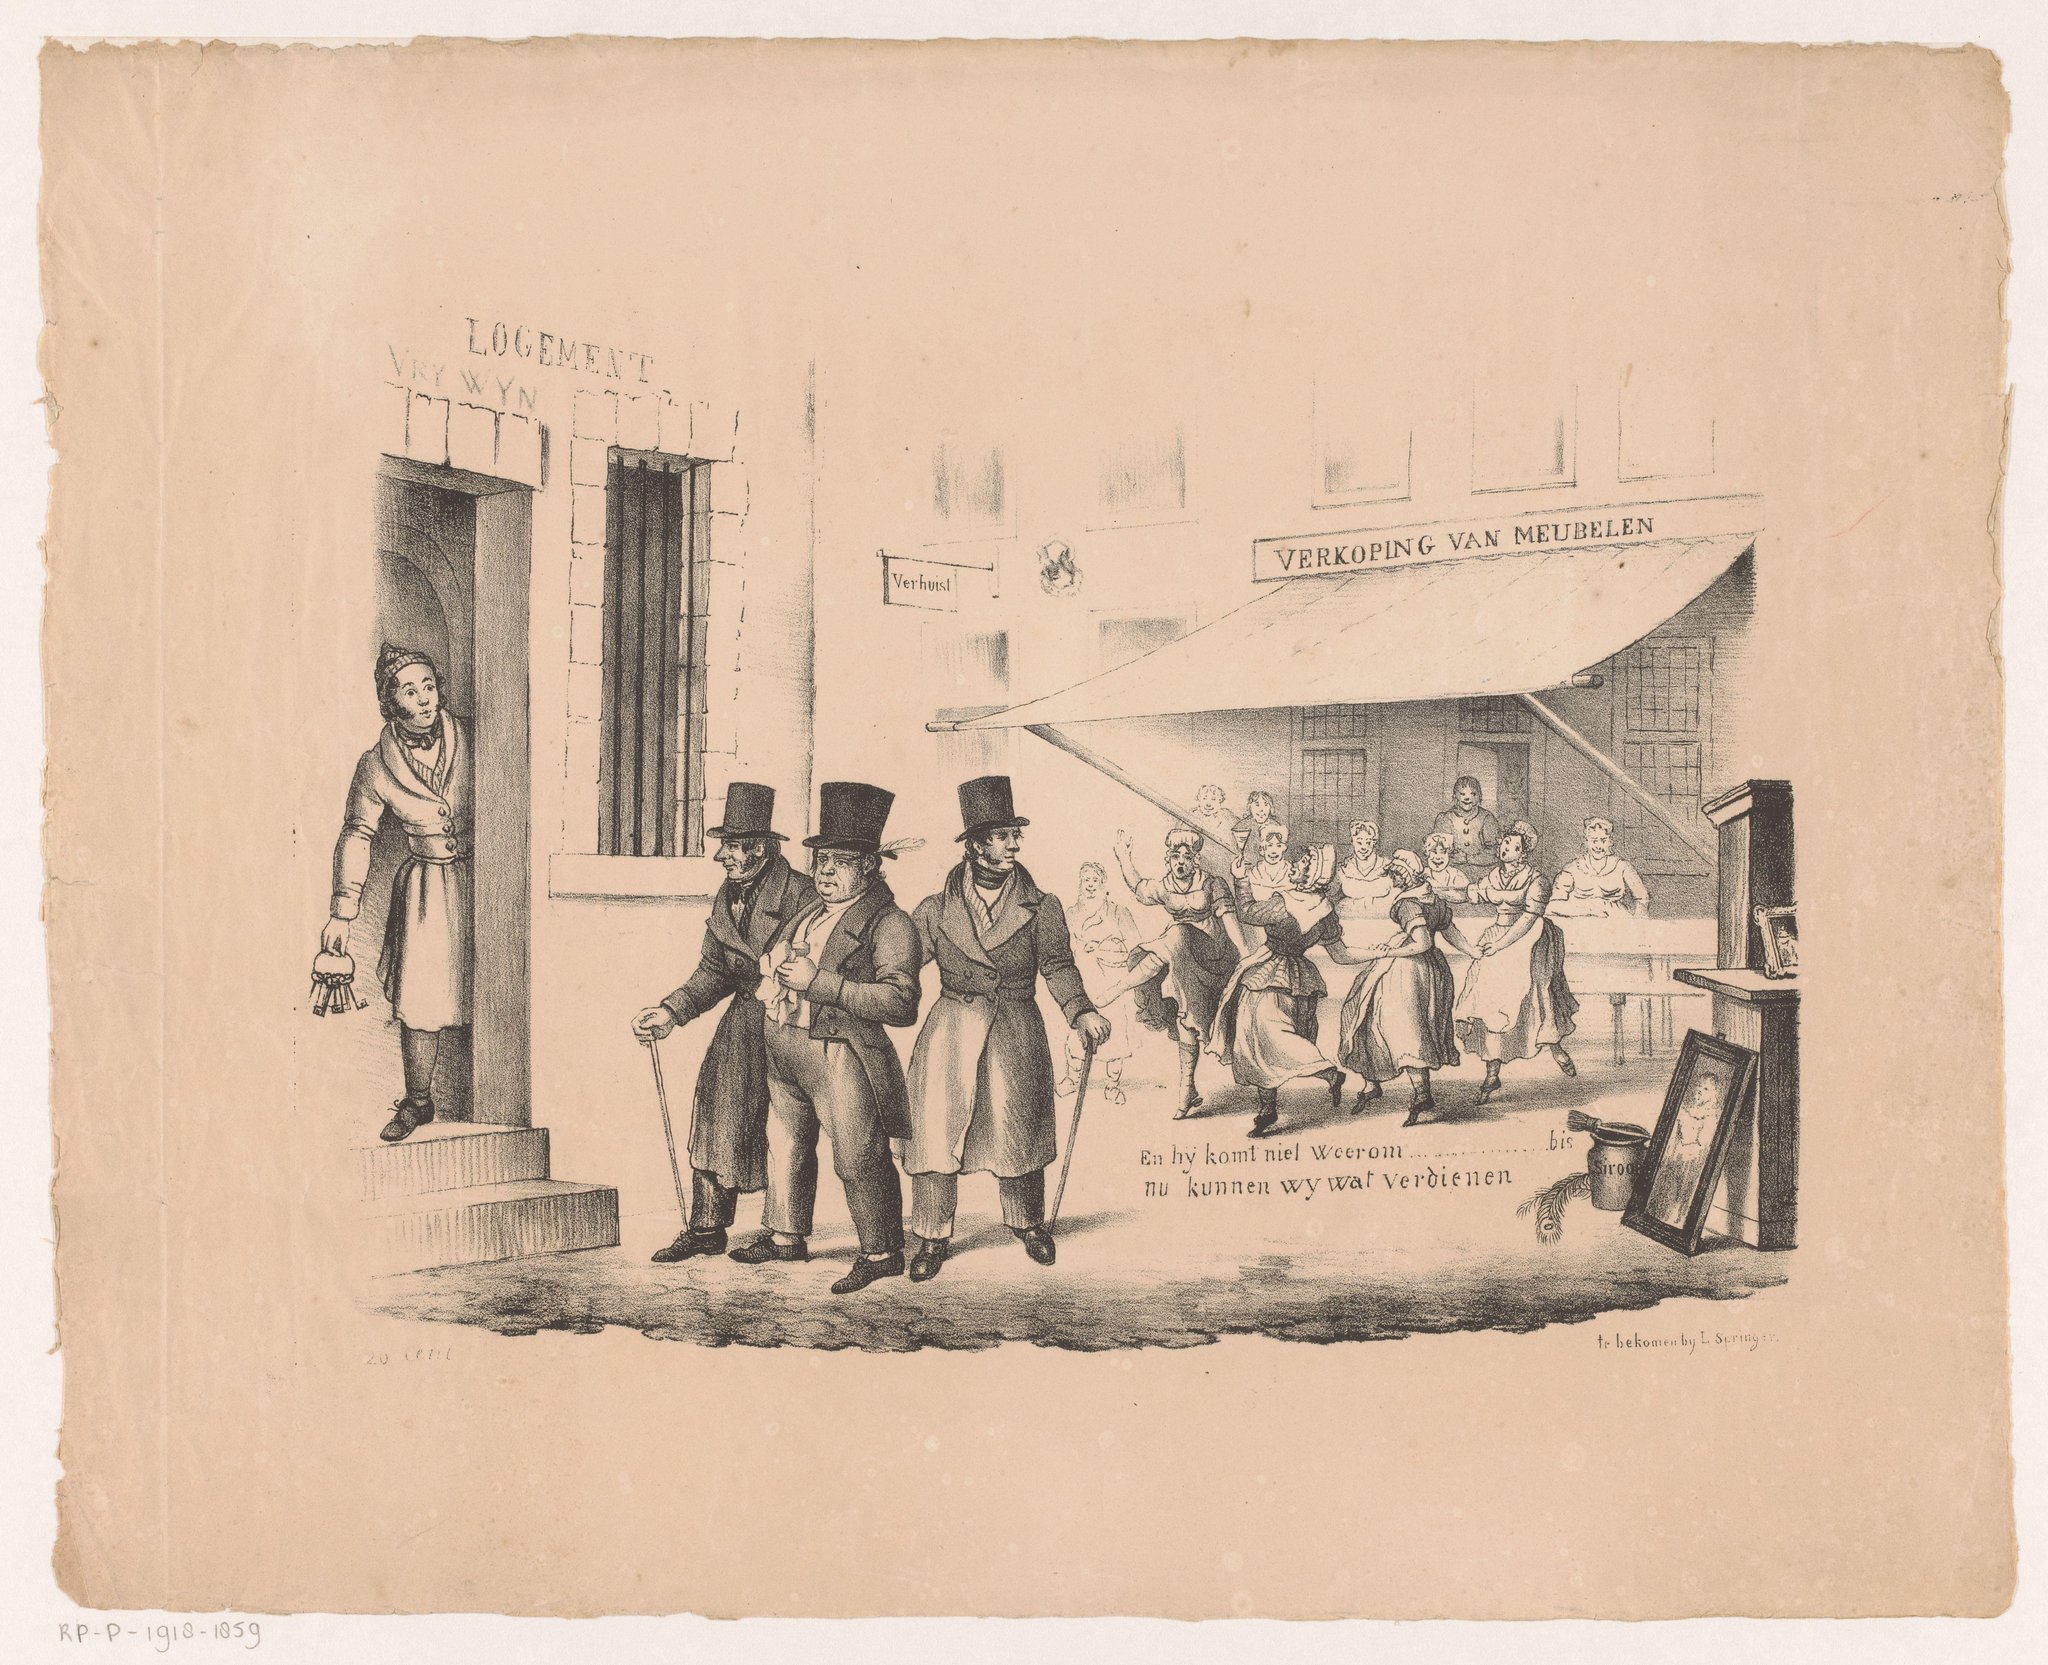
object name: print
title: Spotprent op C. Seyn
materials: paper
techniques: lithograph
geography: leiden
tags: prison, jail, transport (of arrested person), leiden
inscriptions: collector's mark: Lugt 2233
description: Spotprent op de Leidse klerk C. Seyn die door twee agenten naar de gevangenis wordt geleid. Op de achtergrond een venduhuis voor meubelen waar een groep vrouwen zingen en dansen van blijdschap over de arrestatie. Ten behoeve van zijn liefhebberij (schilderijen) stal Seyn uit de stadskas. Rechts enkele schilderijen geleund tegen een kast, een pot siroop en een pauwenveer. De diefstal werd ontdekt op 10 oktober 1838, het vonnis uitgesproken op 27 september 1839.